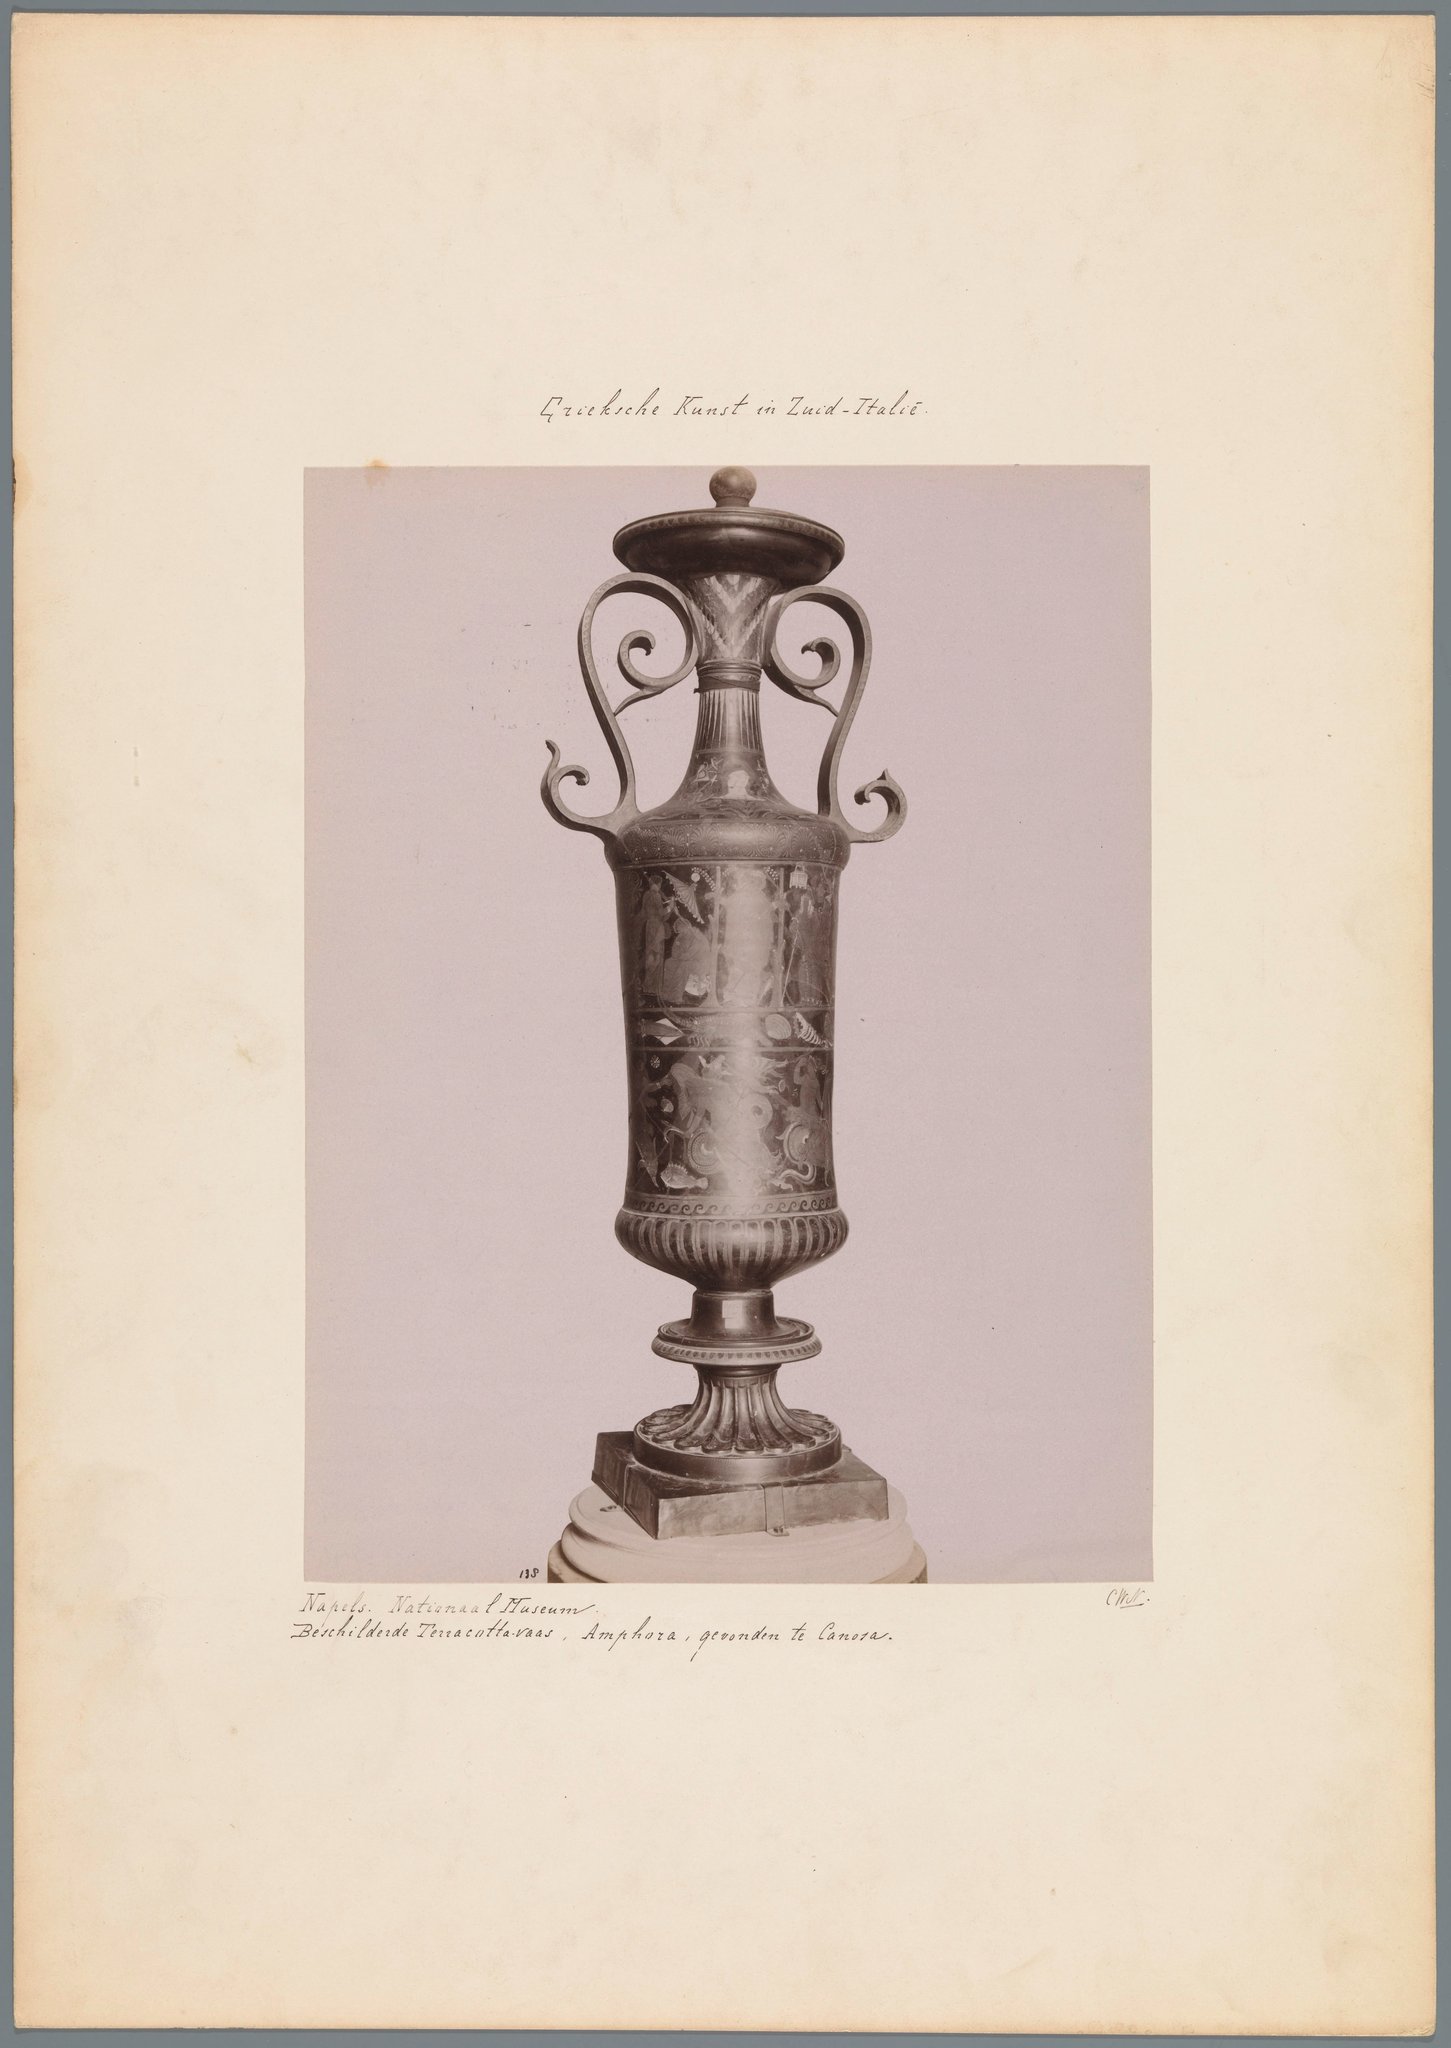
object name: photograph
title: Beschilderde terracotta vaas in het Museo Nazionale te Napels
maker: Anonymous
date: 1875-1900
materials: cardboard, photographic support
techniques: albumen print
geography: naples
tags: container of ceramics: jar, jug, pot, vase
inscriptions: inscription: ‘Grieksche Kunst in Zuid-Italië. Napels. Nationaal Museum. Beschilderde Terracotta-vaas , Amphora , gevonden te Canosa.’, number: ‘138’, collector's mark: ‘INSTITUUT VOOR KUNST- NIJVERHEIDSONDERWIJS GABRIËL METSUSTRAAT No. 16. AMSTERDAM’, collector's mark: ‘KUNSTNIJVERHEIDSCHOOL QUELLINUS AMSTERDAM FRANS HALSSTRAAT 14.’, inscription: ‘CWN.’